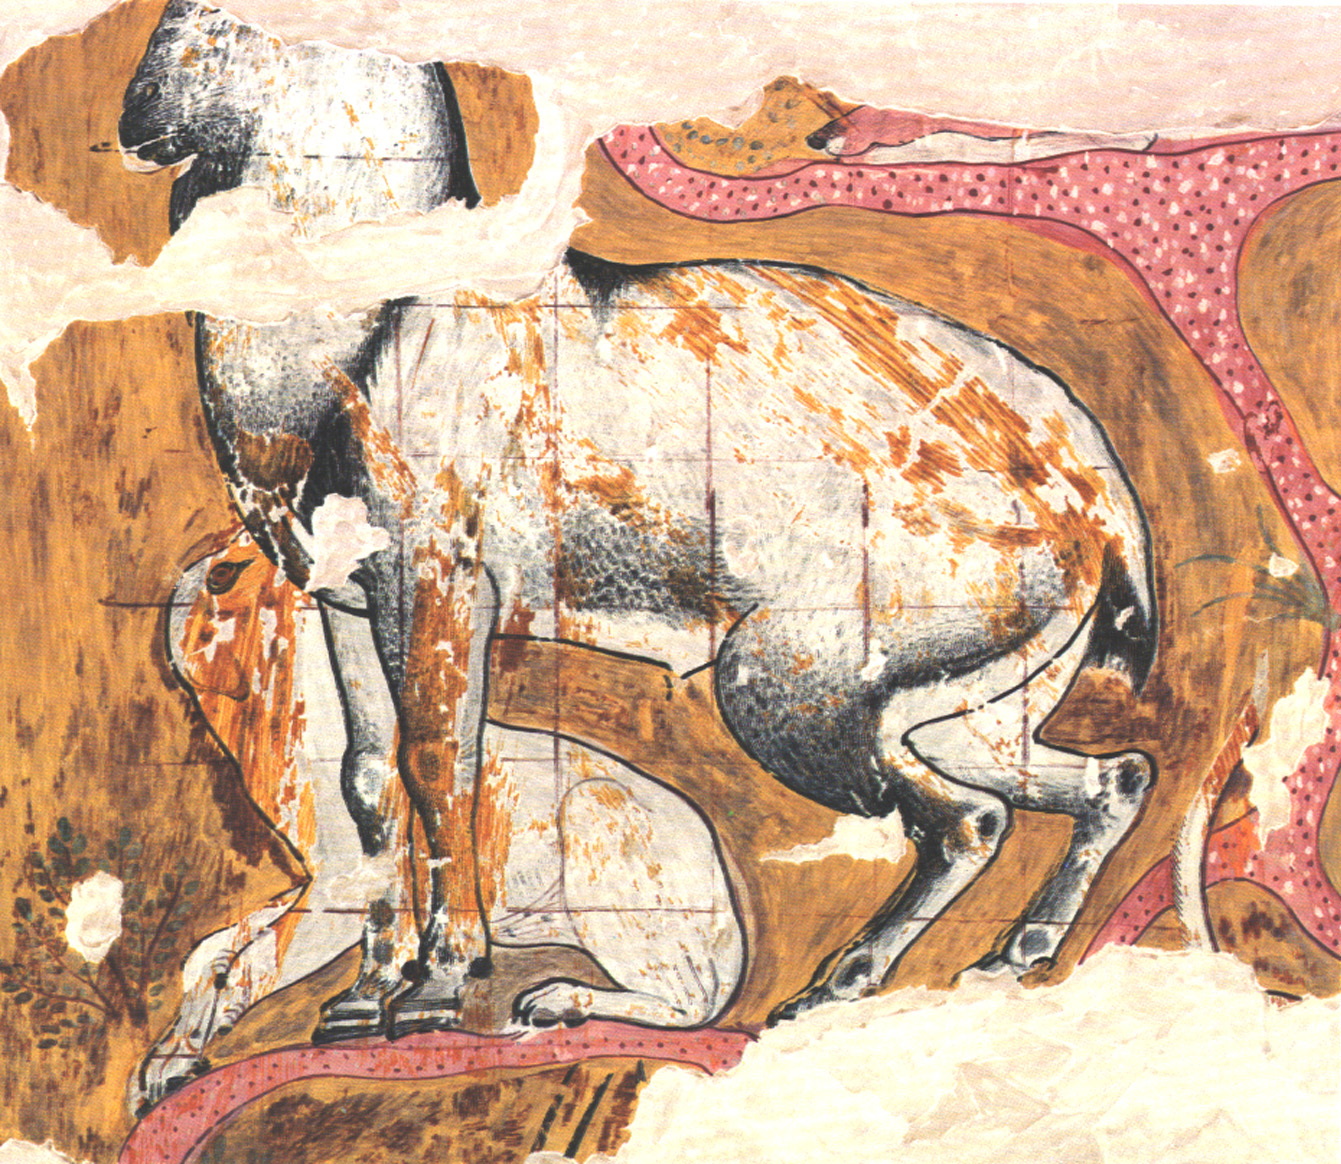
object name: facsimile, qenamun tt 93, hunting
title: Ibex and Dog from the Tomb of Qenamun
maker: nina de garis davies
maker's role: artist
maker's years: 1881-1965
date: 1427-1400 BCE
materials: paper, paint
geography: egypt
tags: dogs,ibex